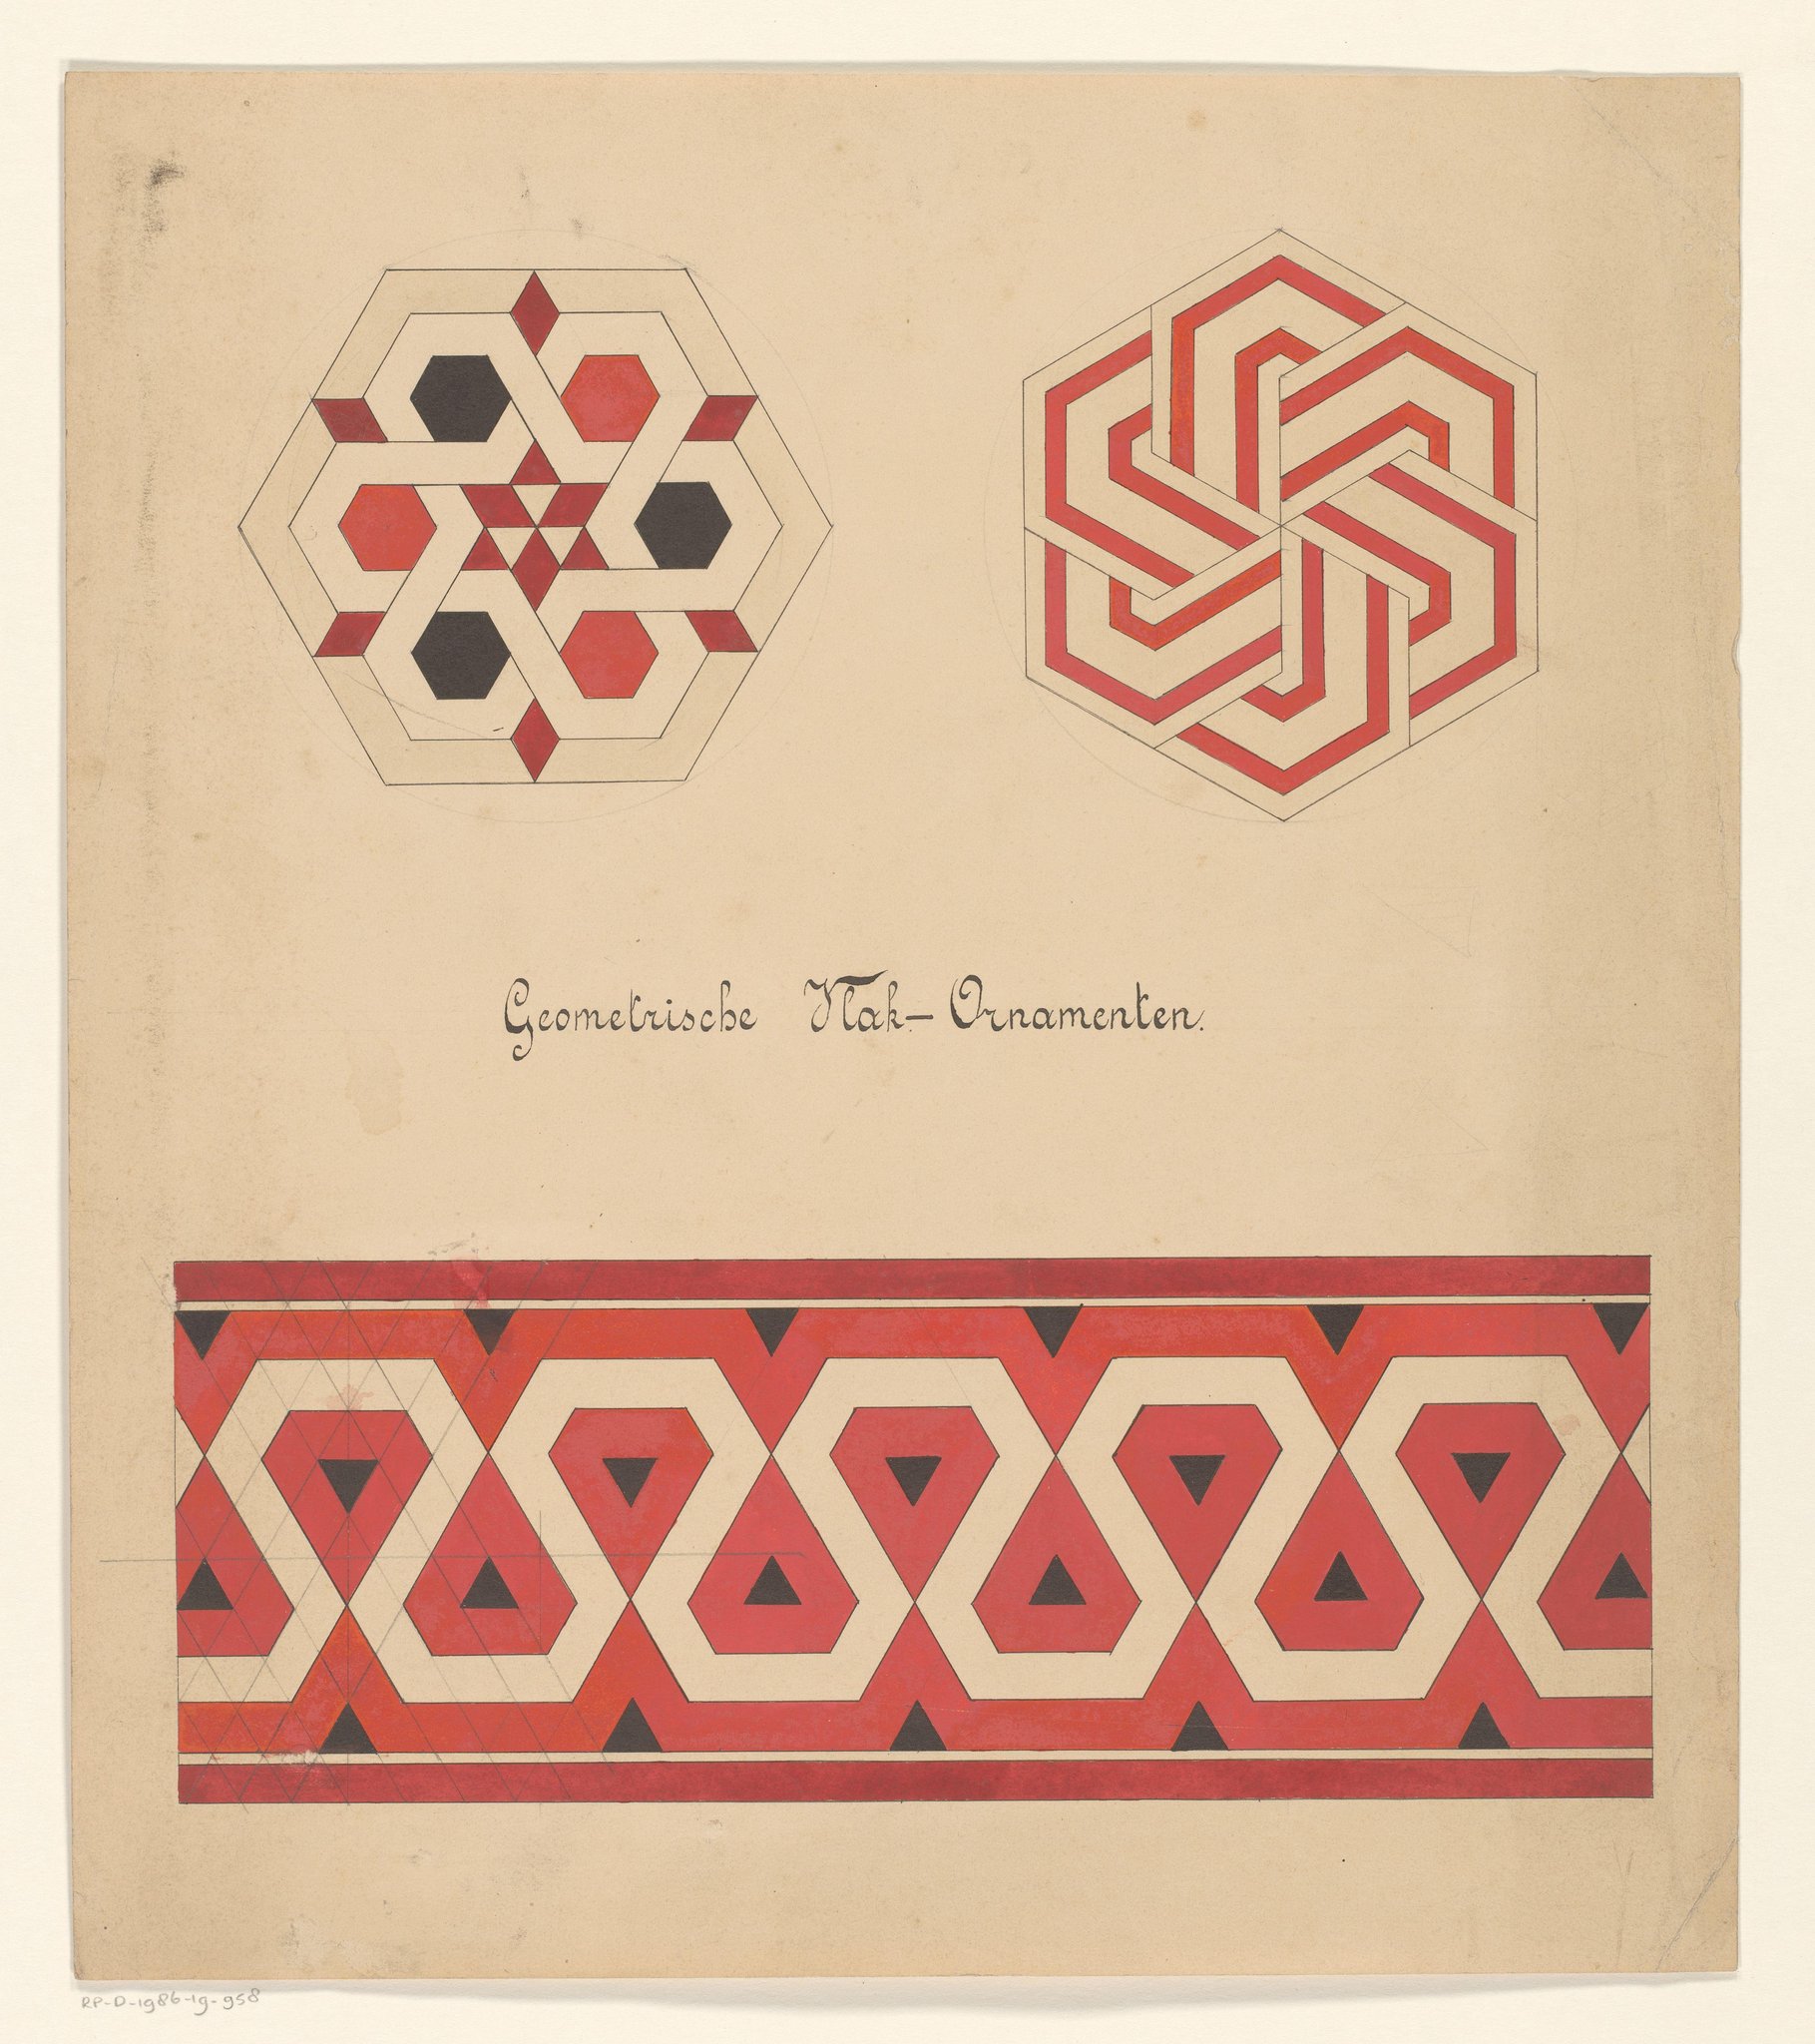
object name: drawing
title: Drie geometrische vlakornamenten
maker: reinier willem petrus de vries (1874-1953)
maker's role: draughtsman, print maker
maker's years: 1874-1953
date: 1884-1952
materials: paint, ink, paper, pencil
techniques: brush, pen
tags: ornament ~ geometric motifs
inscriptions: inscription: ‘Geometrische Vlak-Ornamenten.’, collector's mark: ‘R:MVS.’